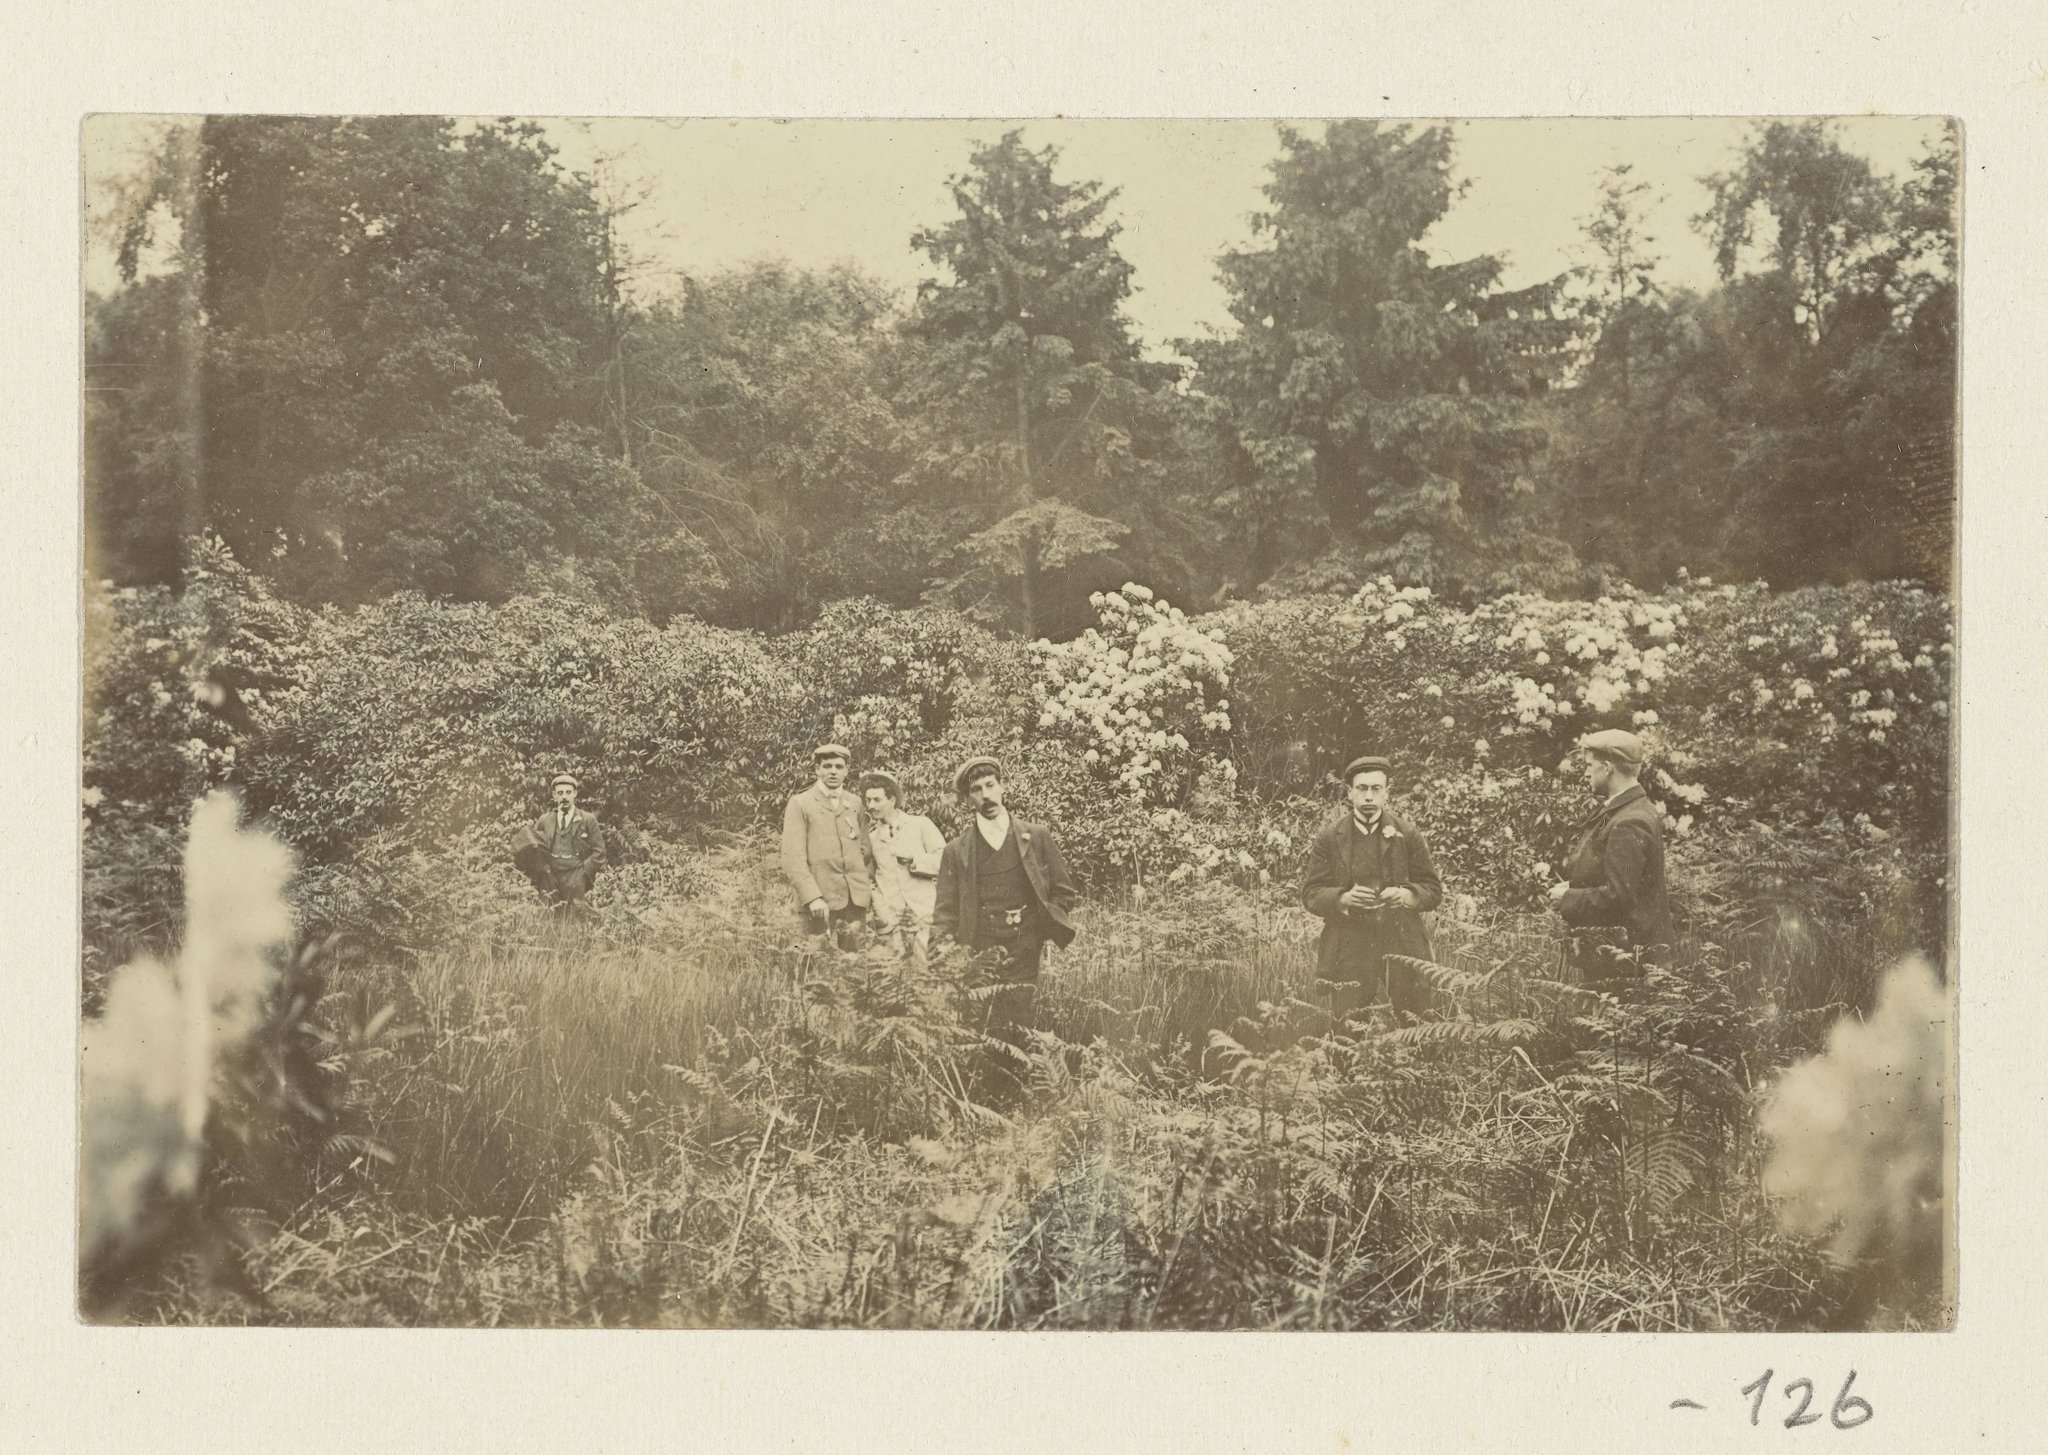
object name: photograph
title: De vrienden van Dolph Kessler in het struikgewas van een bos bij Gainsborough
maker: geldolph adriaan kessler (dolph)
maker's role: fotograaf, industrieel, voetballer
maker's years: 1884-1945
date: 1903-1904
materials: cardboard, photographic support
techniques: gelatin silver print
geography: gainsborough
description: De vrienden van Dolph Kessler in het struikgewas van een bos bij vermoedelijk Gainsborough. Onderdeel van het fotoalbum van Dolph Kessler met opnamen die hij maakte tijdens zijn verblijf in Engeland en op een wereldreis die hij als secretaris van Henri Deterding (directeur Koninklijke Olie) ondernam naar Nederlands-Indië, Japan, China en de Verenigde Staten, tussen 1906 en 1908.